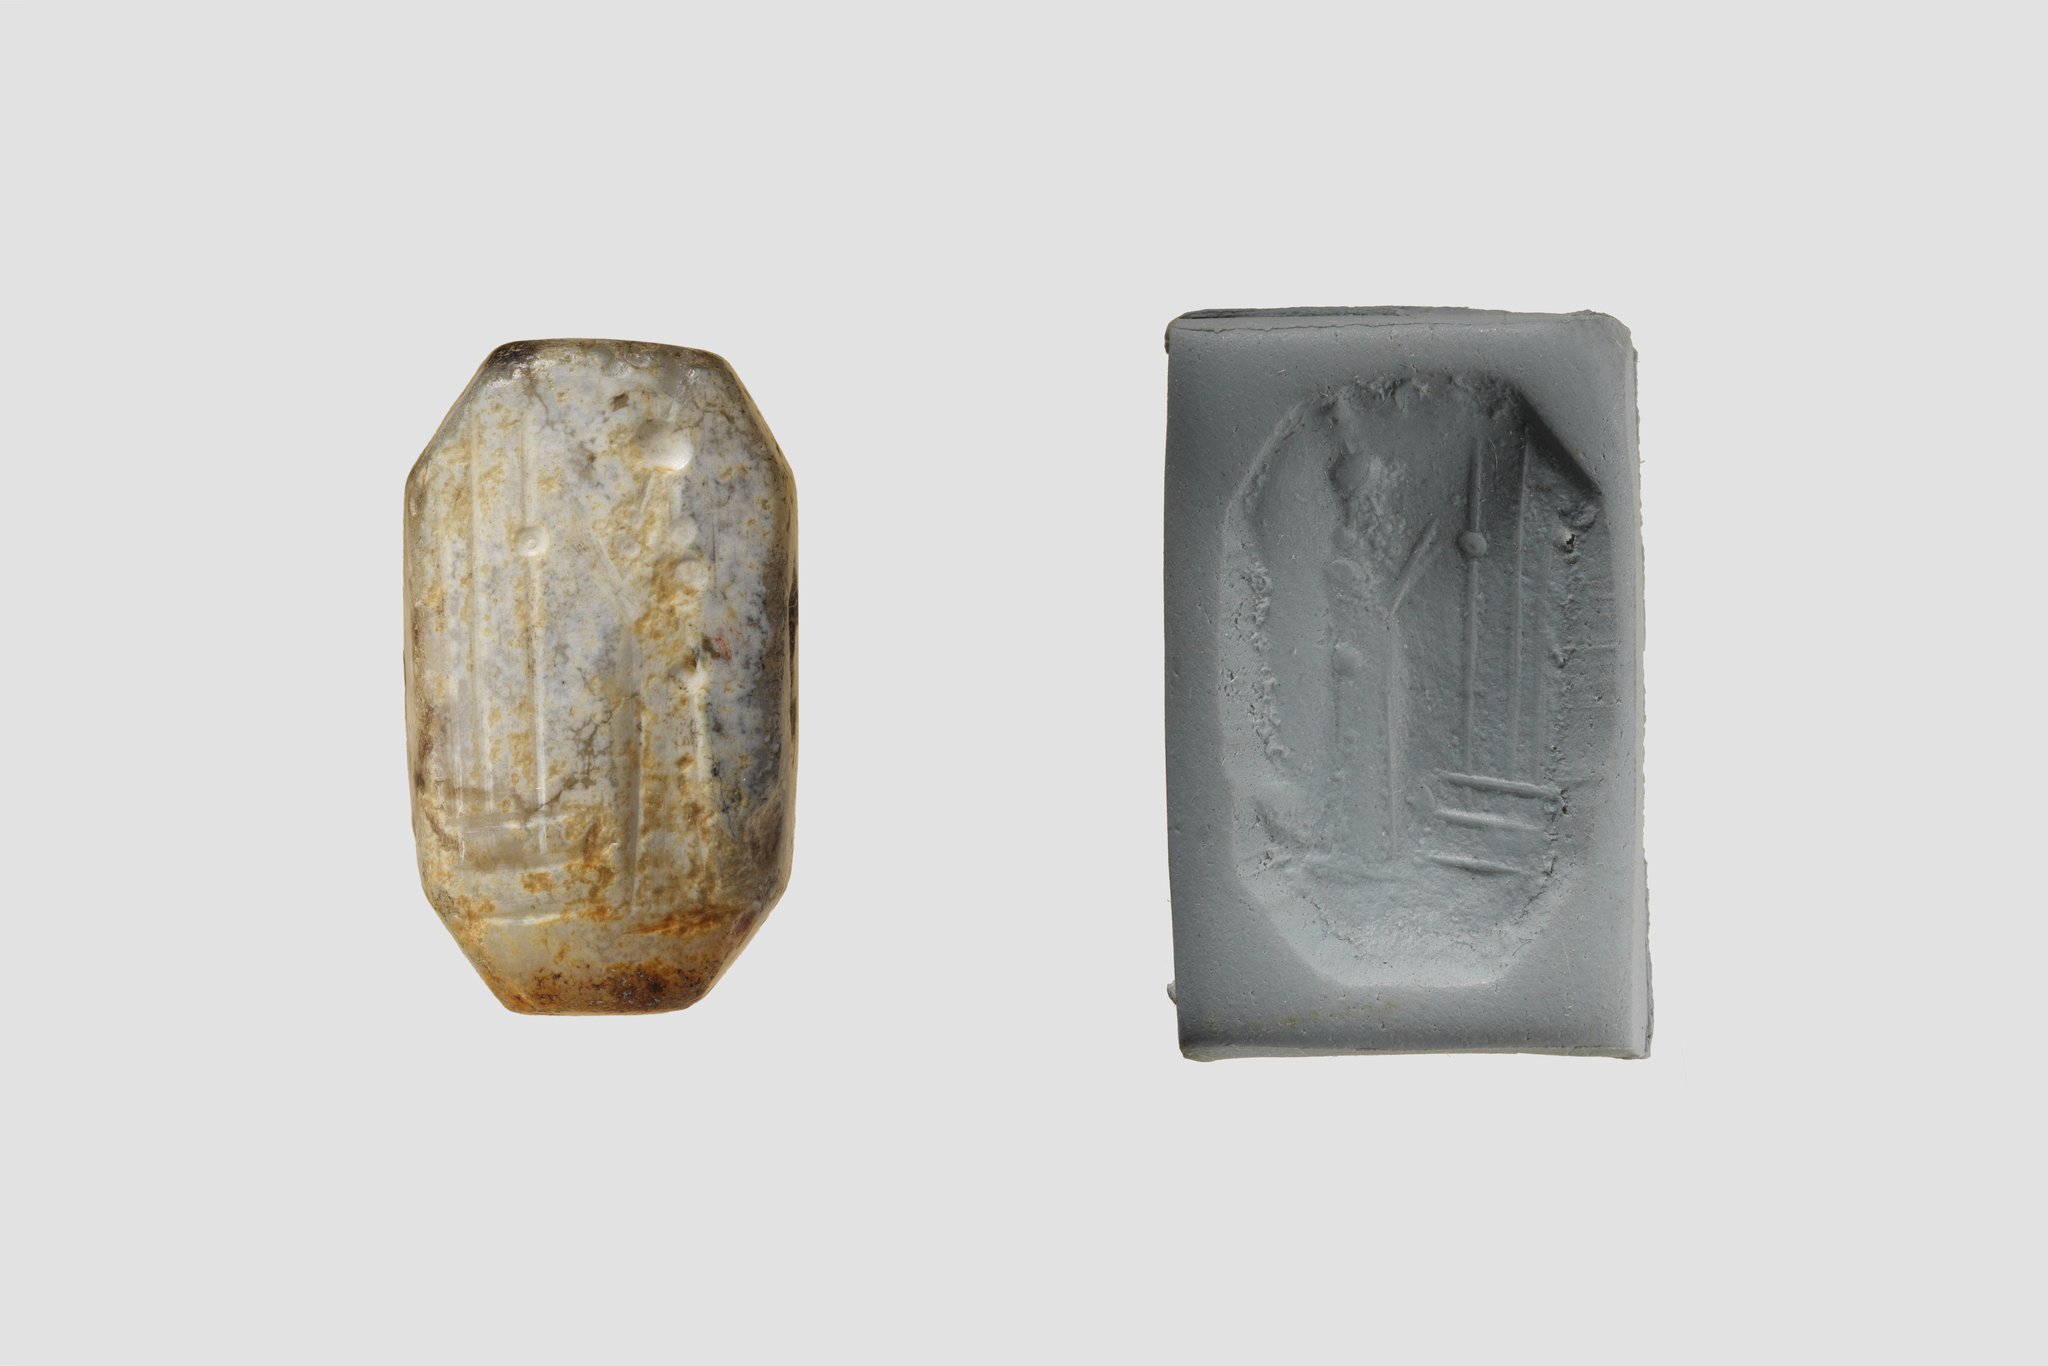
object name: stamp seal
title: Stamp seal (octagonal pyramid) with cultic scene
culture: assyro-babylonian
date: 700-501 BCE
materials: stone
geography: mesopotamia